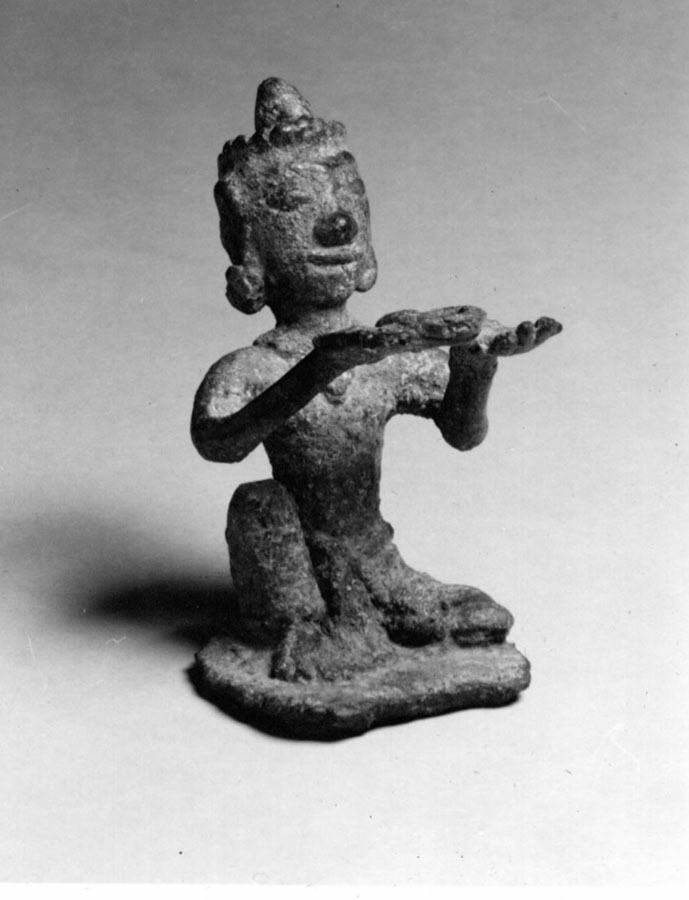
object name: figure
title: Seated Male Figure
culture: vietnamese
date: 701-800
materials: bronze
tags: men